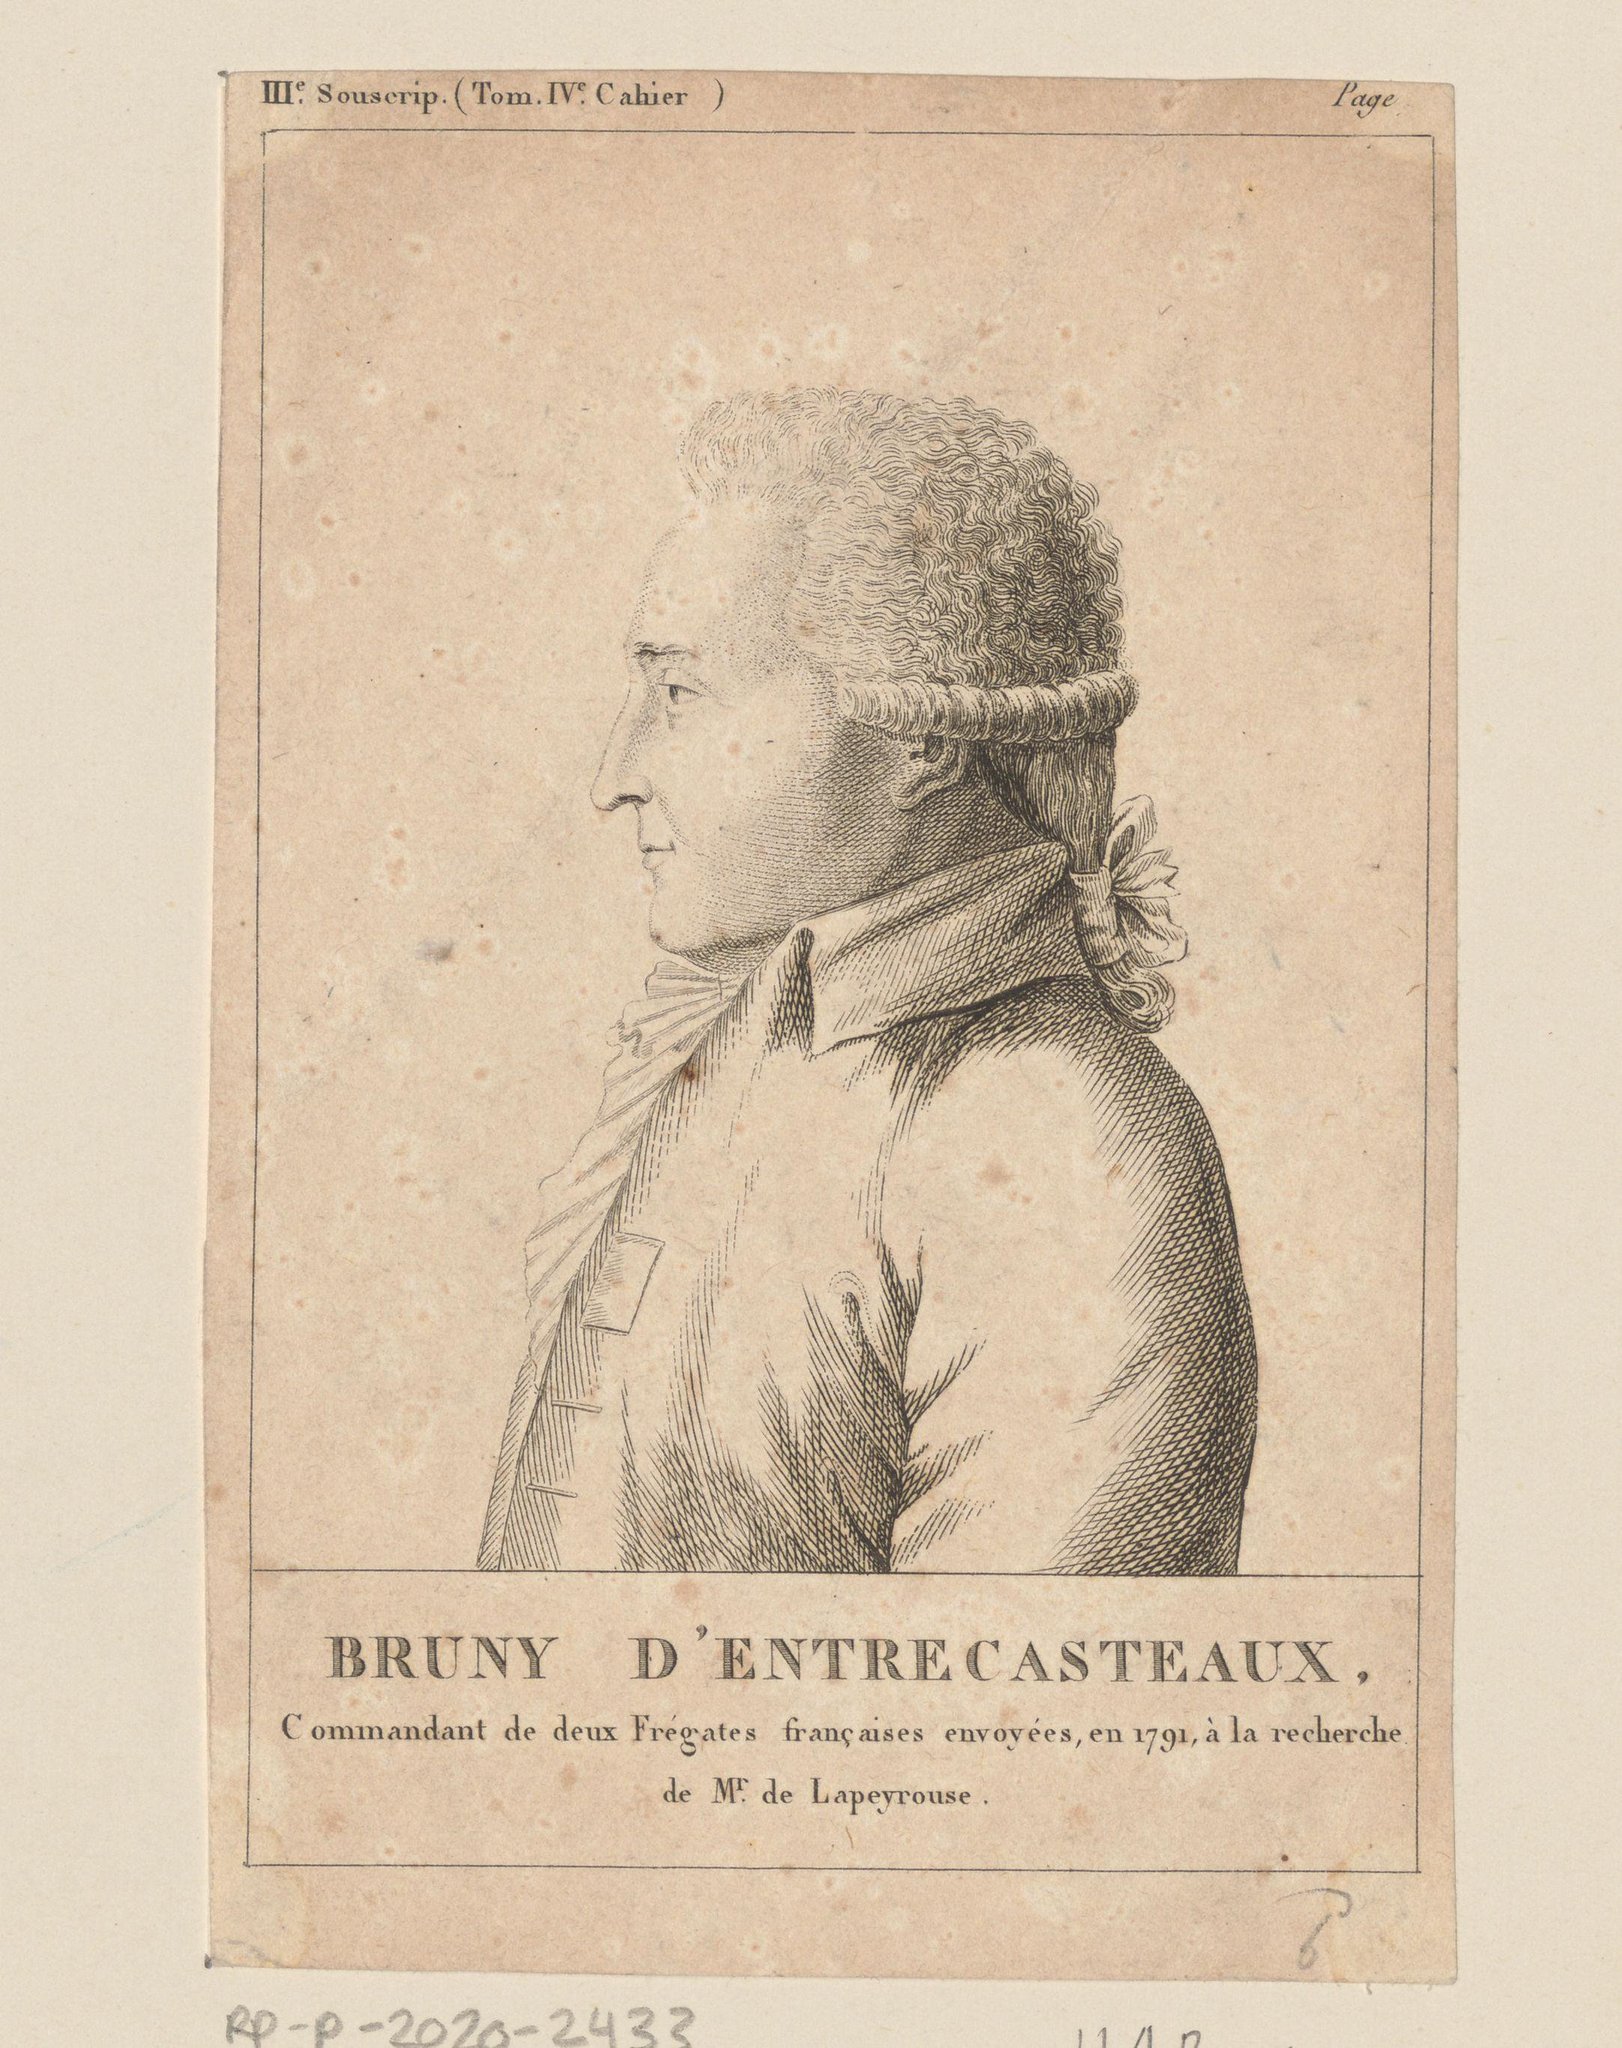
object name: book illustration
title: Portret van Antoine de Bruni d'Entrecasteaux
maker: Anonymous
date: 1791-1810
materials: paper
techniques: engraving, etching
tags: historical persons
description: Prent komt uit een onbekende publicatie.